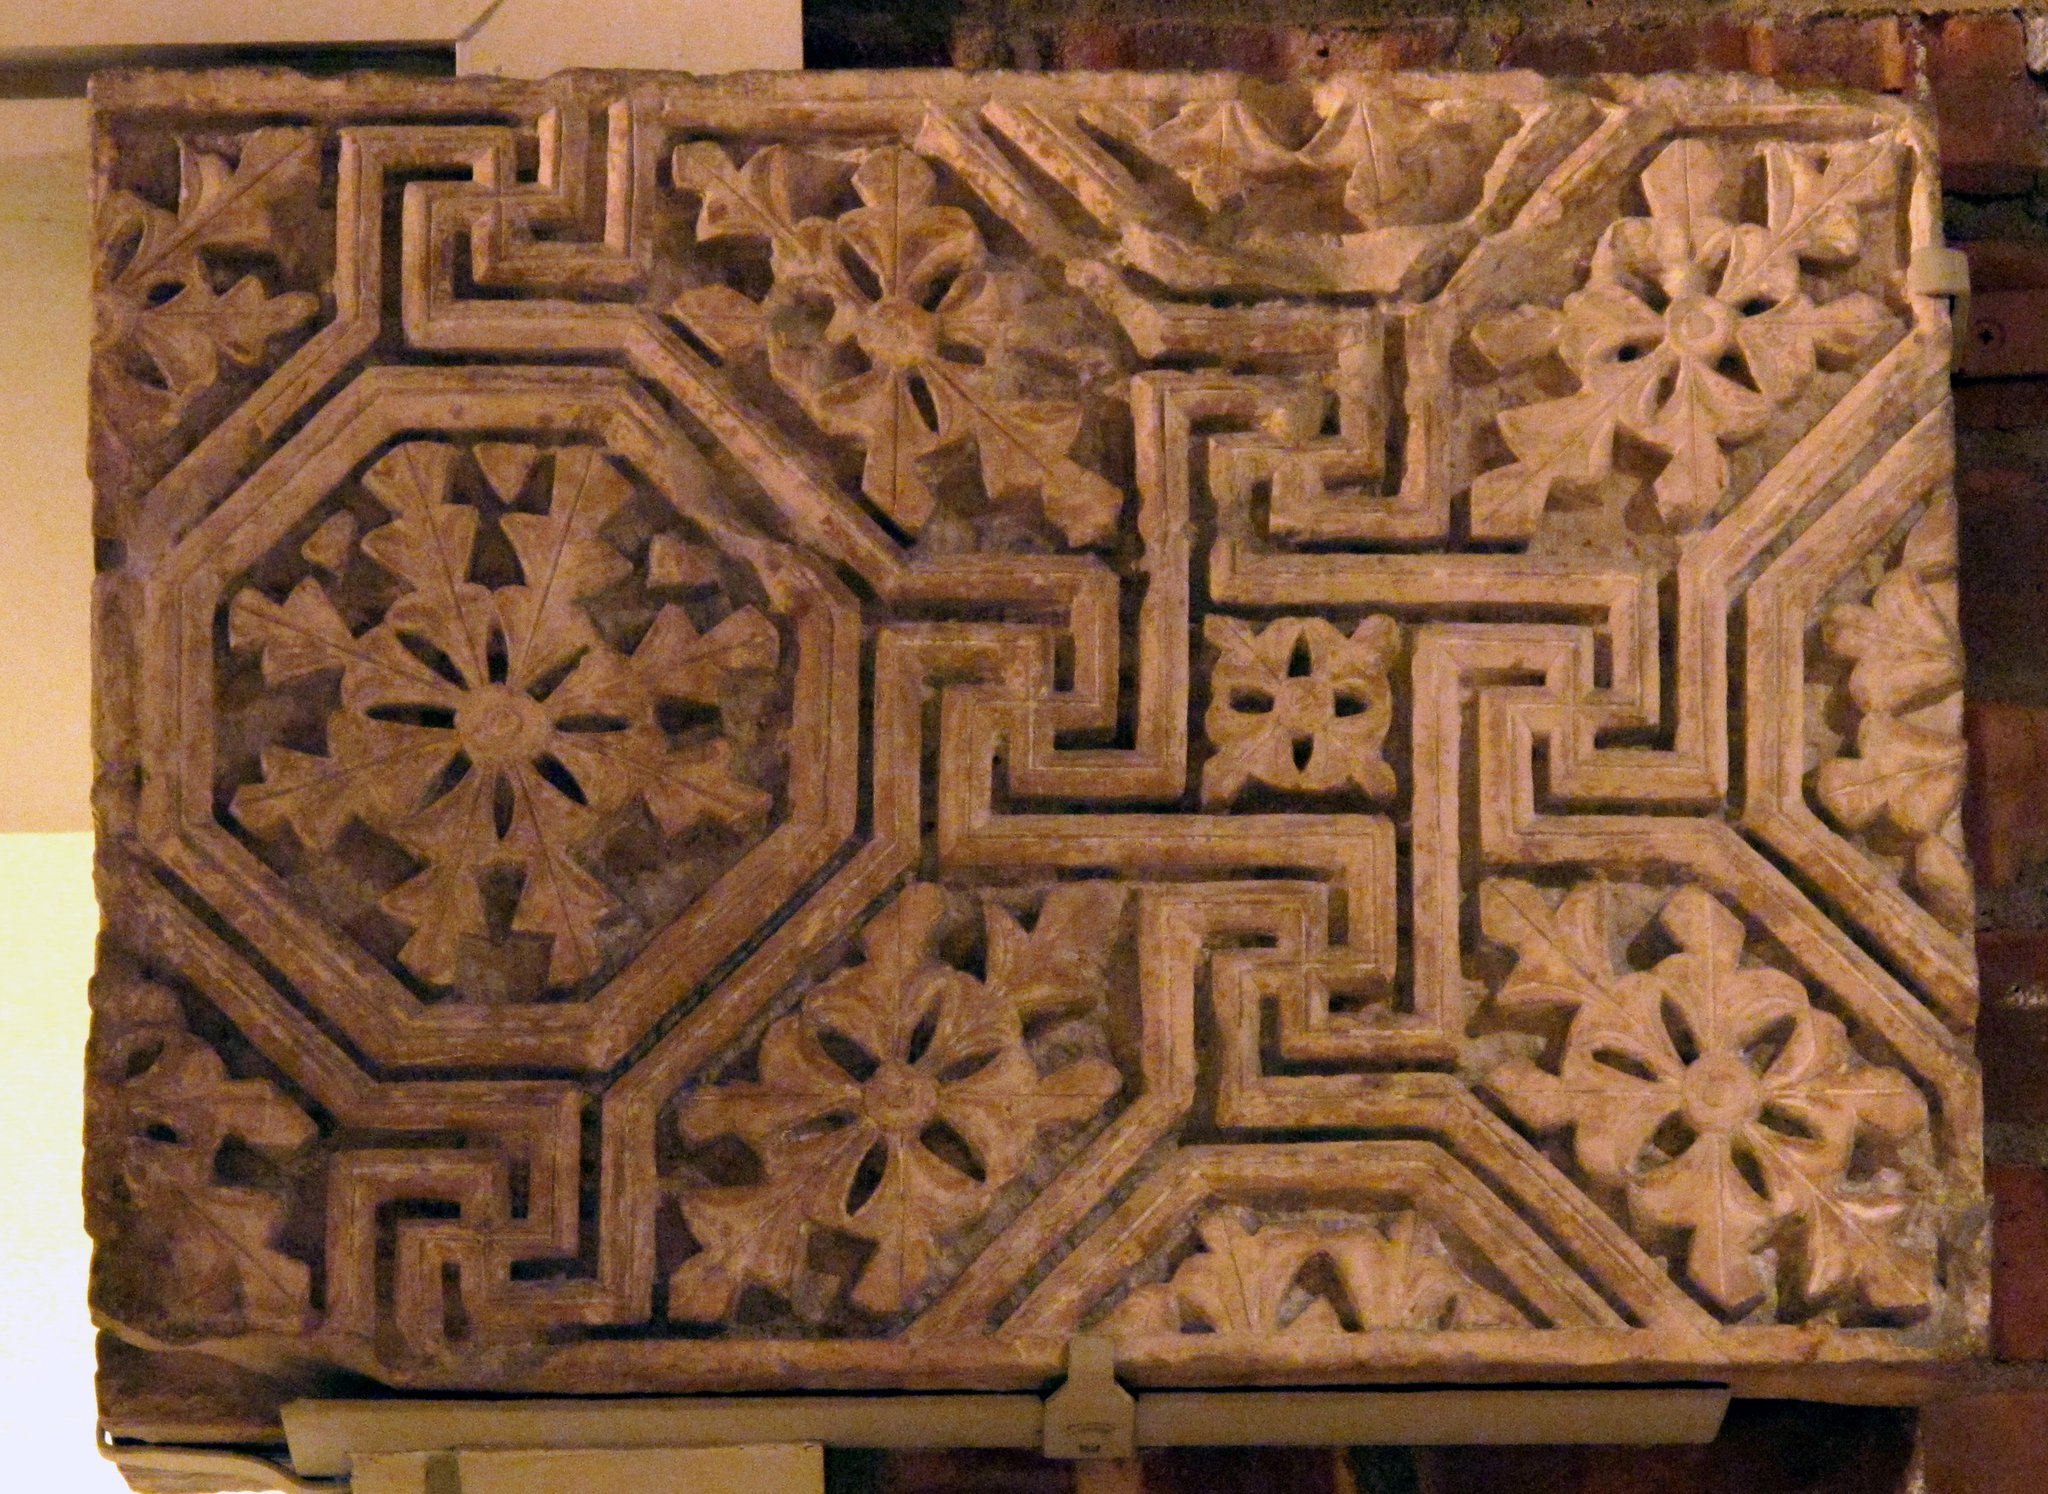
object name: frieze fragment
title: Corner Block from a Frieze with a Meander Pattern of Lines and Rosettes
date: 501-600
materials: limestone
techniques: carving, relief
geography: egypt